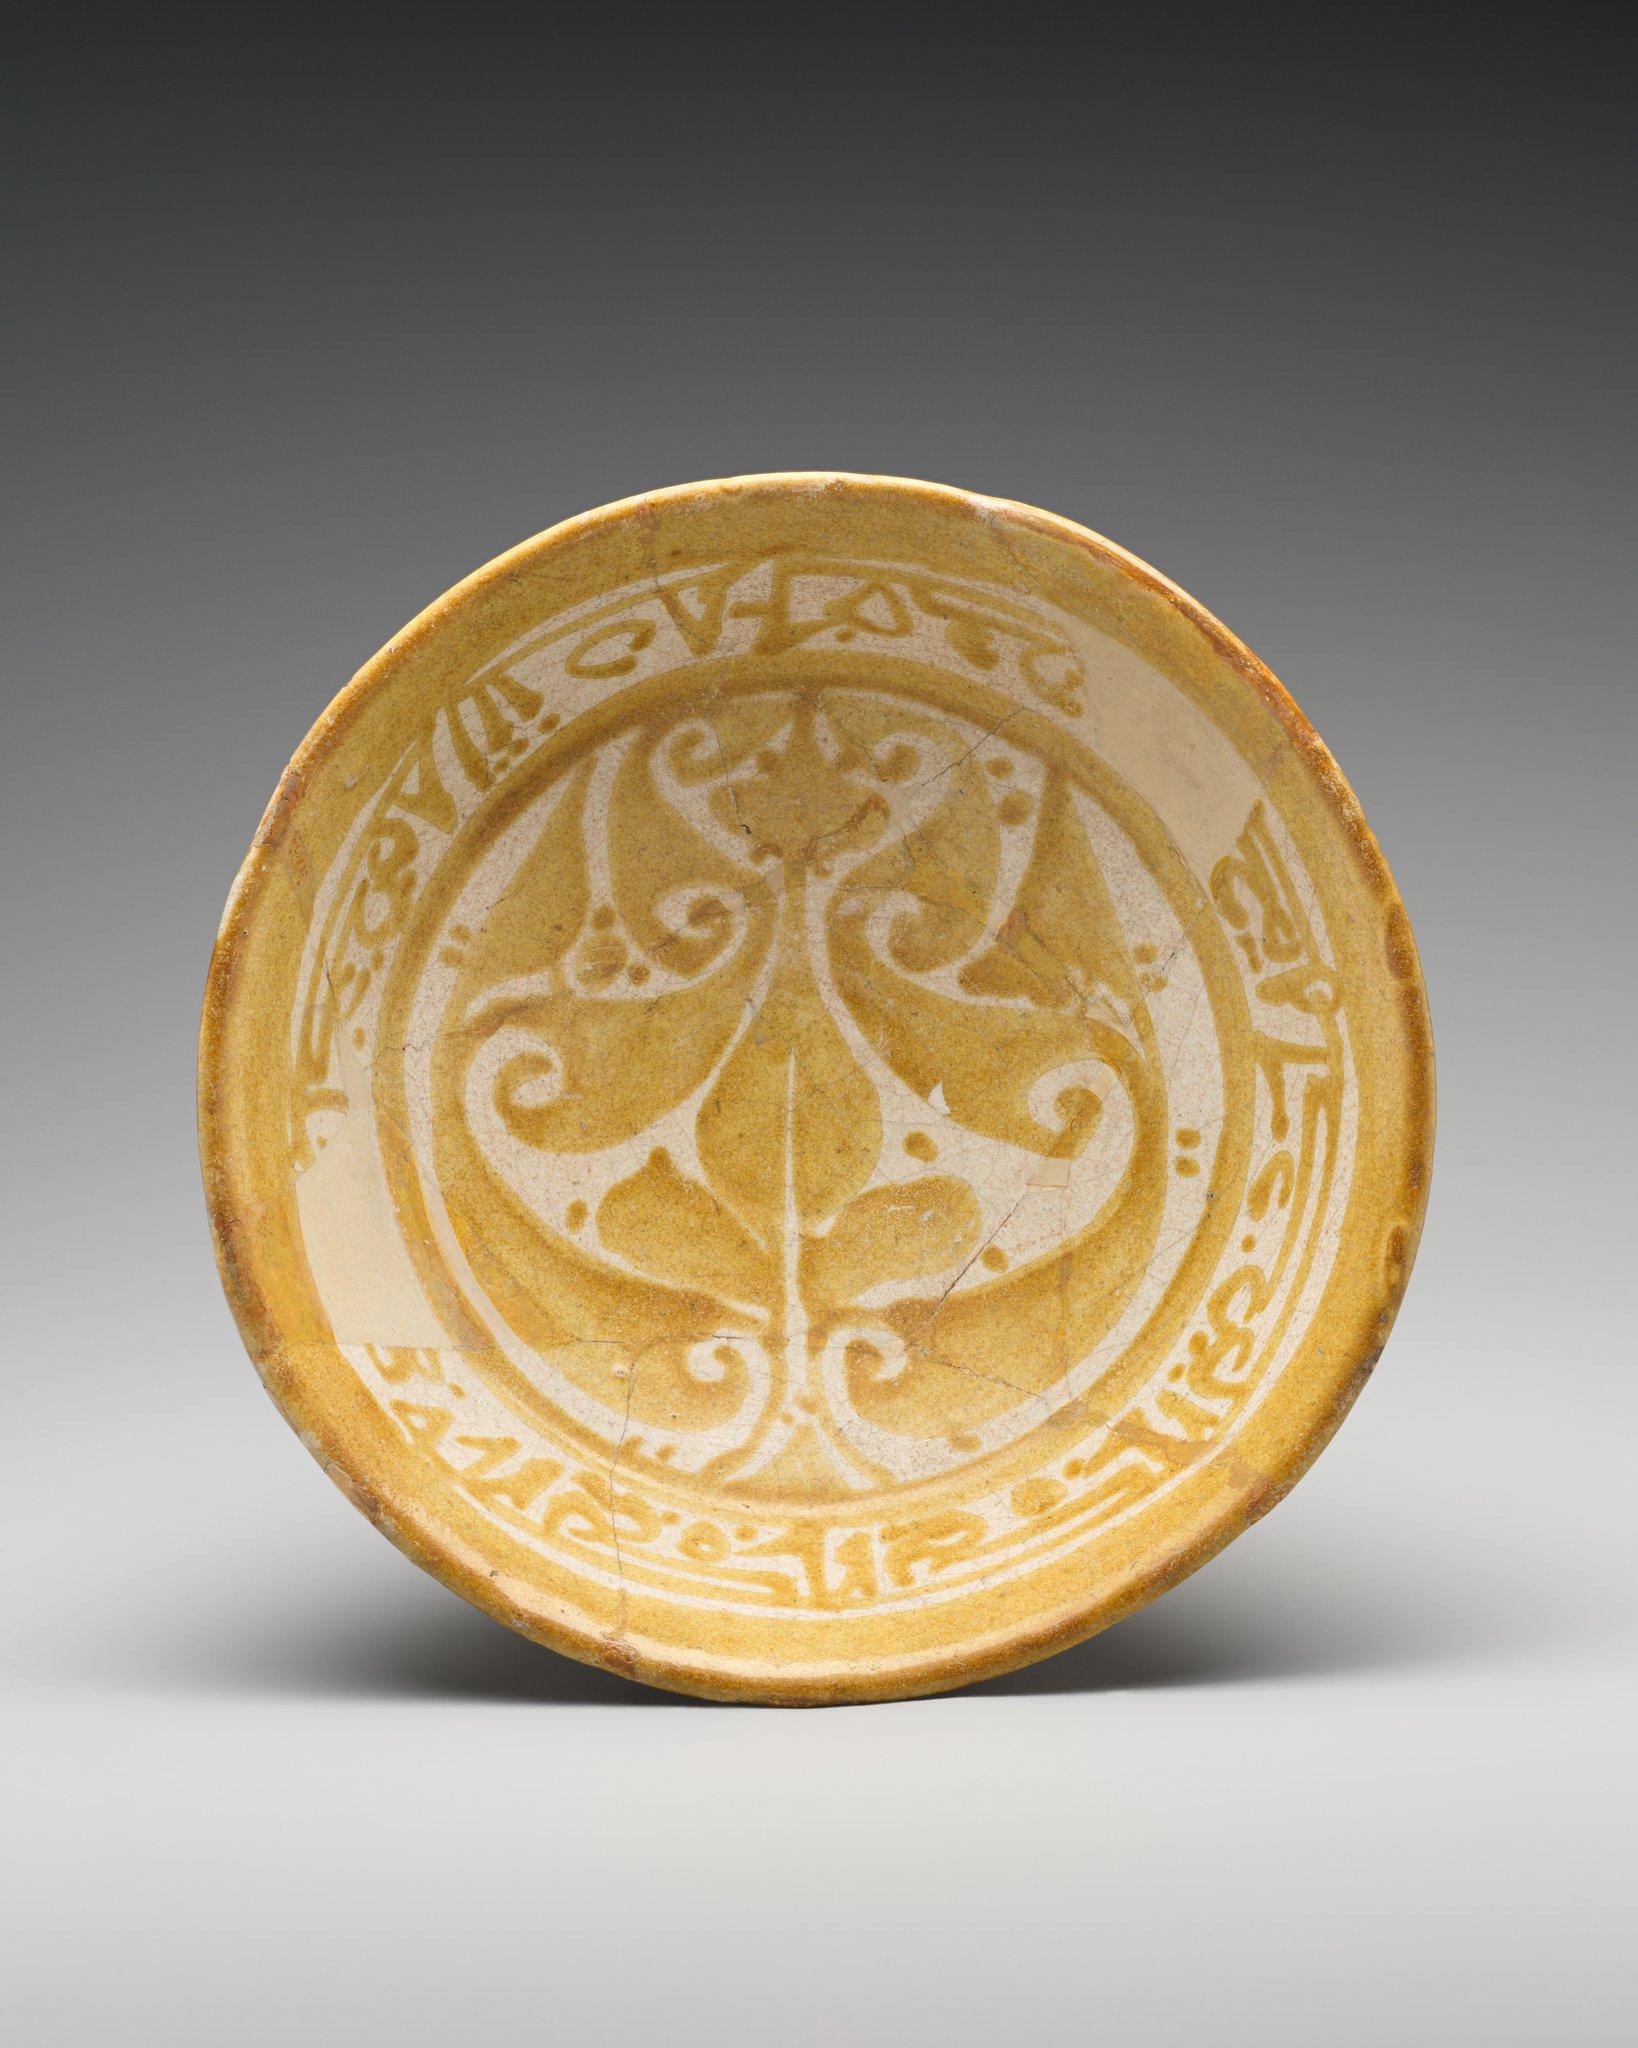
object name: bowl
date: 951-1000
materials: earthenware, glaze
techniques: luster painting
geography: egypt